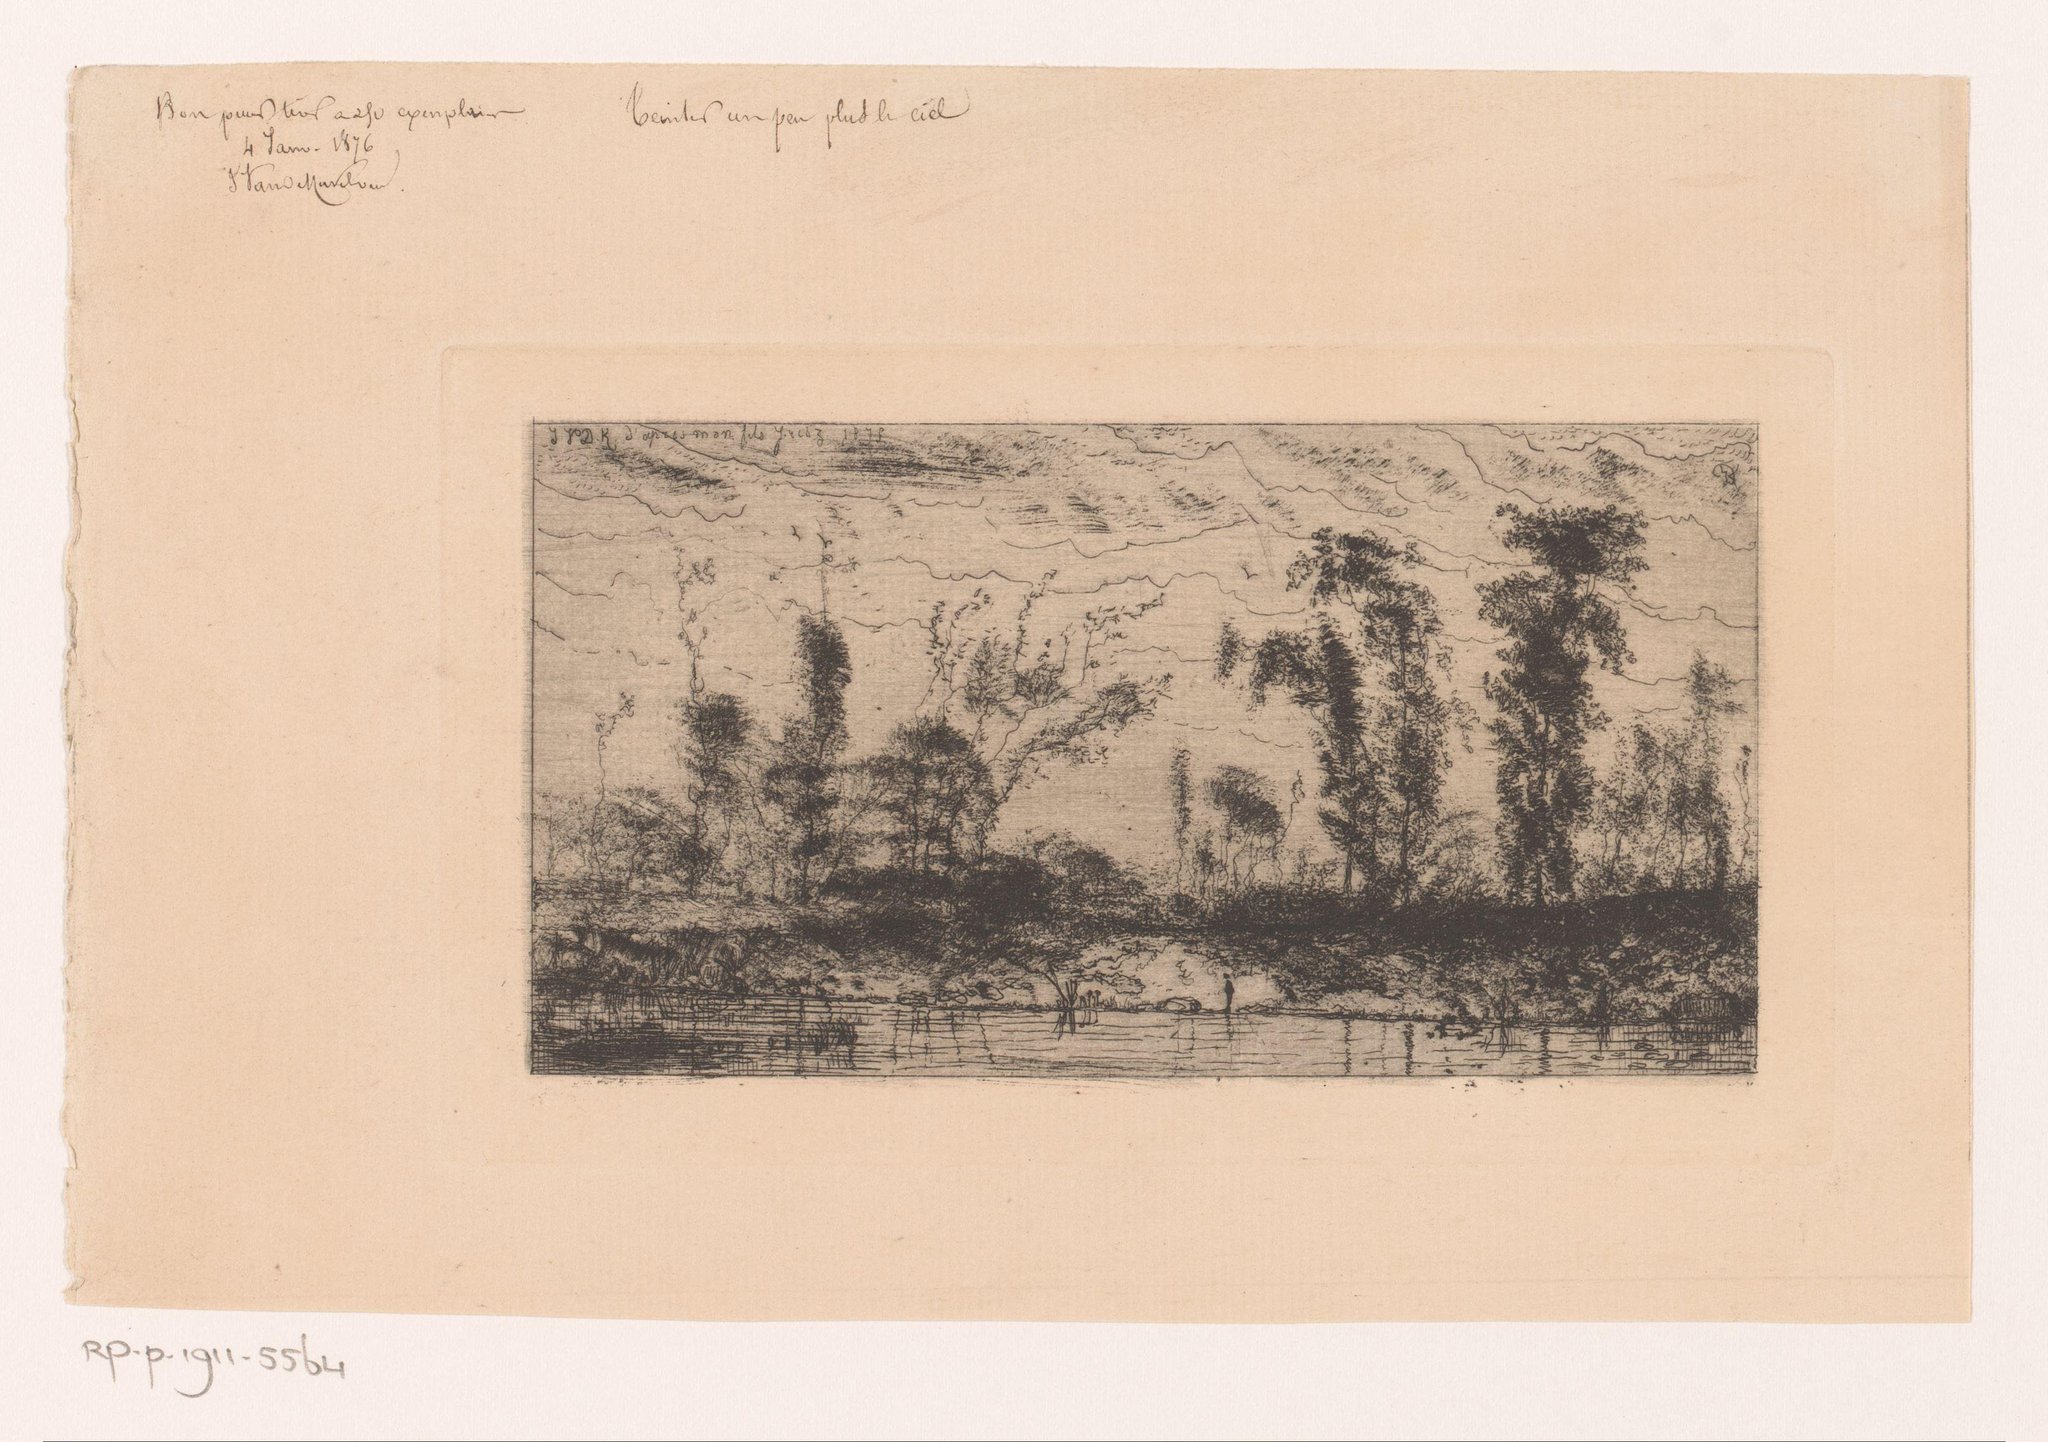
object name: print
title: Figuur op de oever van een rivier met bomen op de achtergrond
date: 1876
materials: paper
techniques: etching, intaglio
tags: river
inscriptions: annotation: ‘Bon pour tirer à 280 exemplaires. 4 Janv. 1876. [Signatuur]. Teinter un peu plus le ciel’, collector's mark: Lugt 2228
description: De etsen naar de schilderijen van Frédéric Van de Kerkhove werden na zijn dood door zijn vader en zuster gemaakt en uitgegeven in twee reeksen. De eerste werd in 1877 uitgegeven door het Journal des Beaux-Arts et de la Littérature: Cahier de 25 Eaux-fortes d'après Frédéric van de Kerkhove, gravées par son père et sa sœur. De tweede reeks van 126 etsen, ook in 1877, werd in Parijs uitgegeven bij A. Lévy onder de titel Cent eaux-fortes gravées par J. Van de Kerkhove d'après les tableaux de Frédéric Van de Kerkhove, mort en 1873 à l'âge de 10 ans et 11 mois.